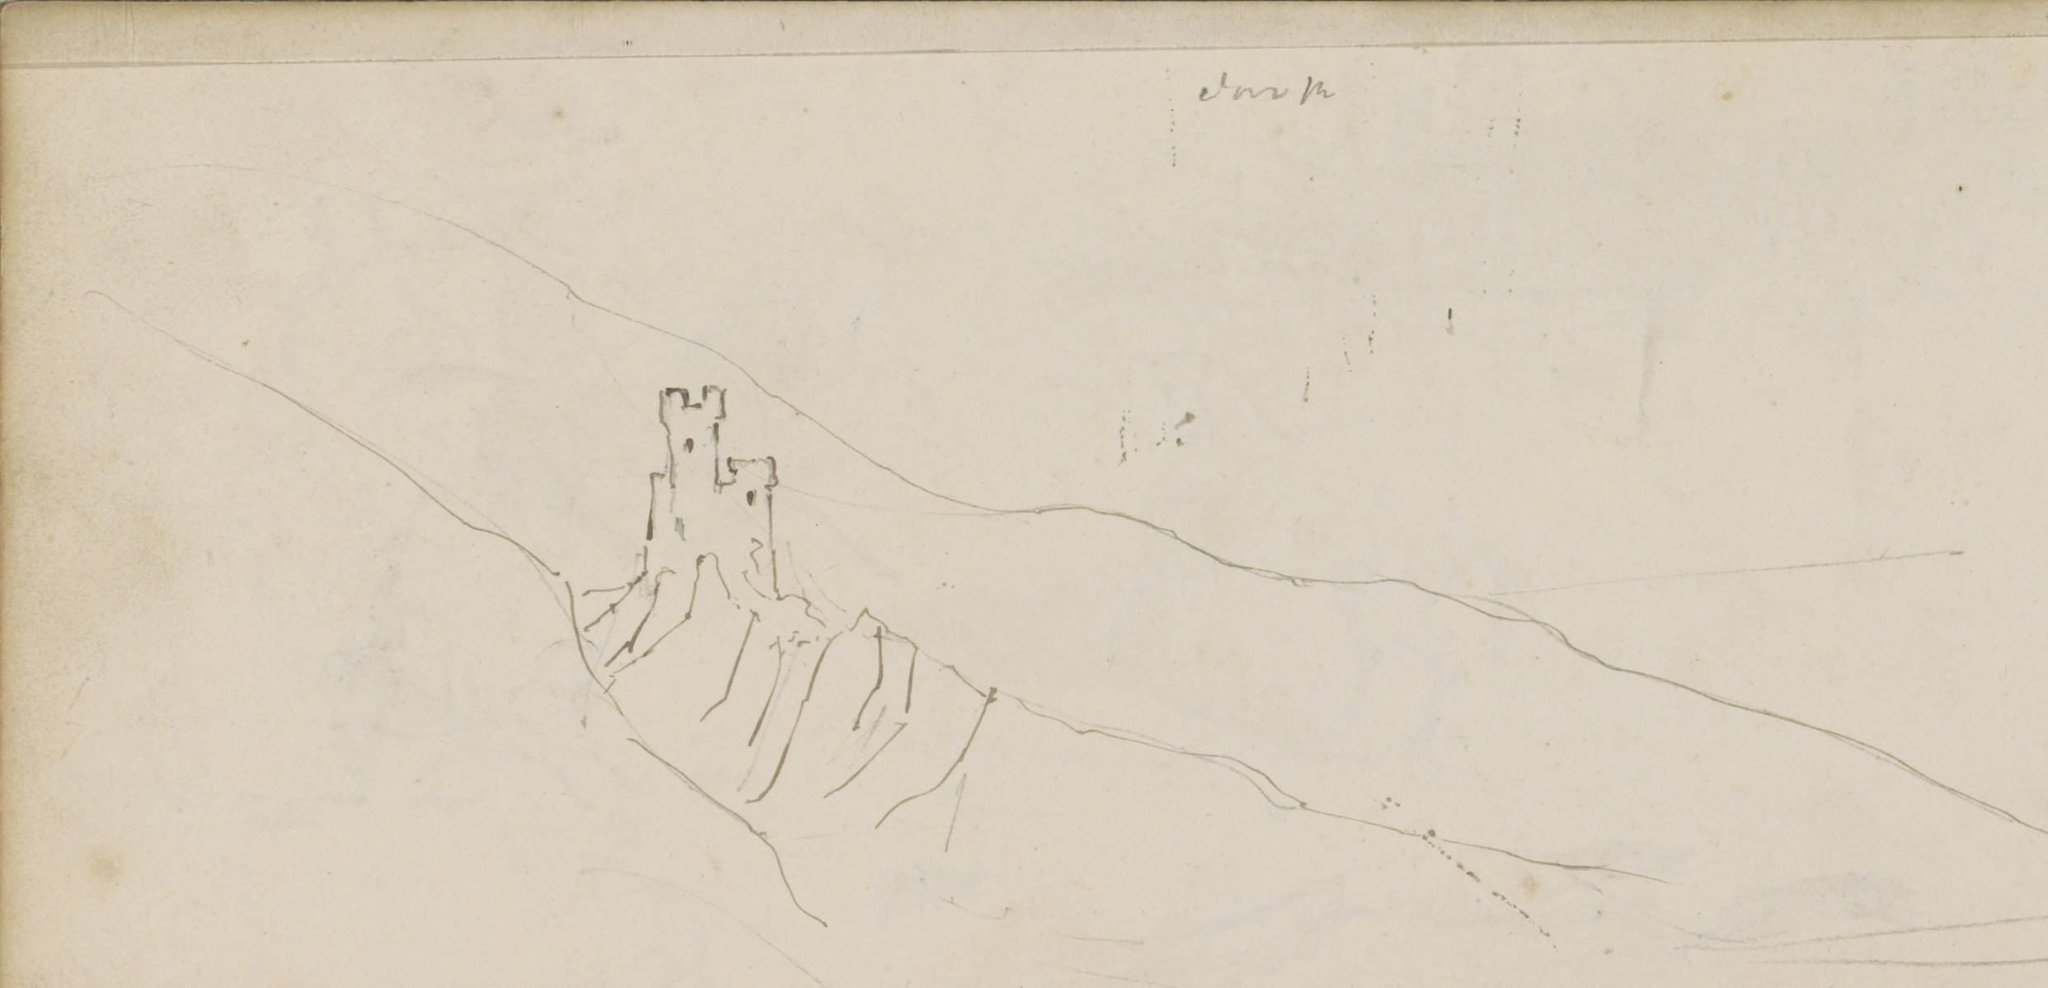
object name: sketchbook leaf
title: Kasteel op een rots tussen de bergen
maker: johannes tavenraat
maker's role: draughtsman, painter, print maker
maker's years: 1809-1881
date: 1840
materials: ink, paper, pencil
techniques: pen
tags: landscape with tower or castle, rocks, mountains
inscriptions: kleurnotitie, handgeschreven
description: Blad 5 verso uit een schetsboek met 63 bladen.